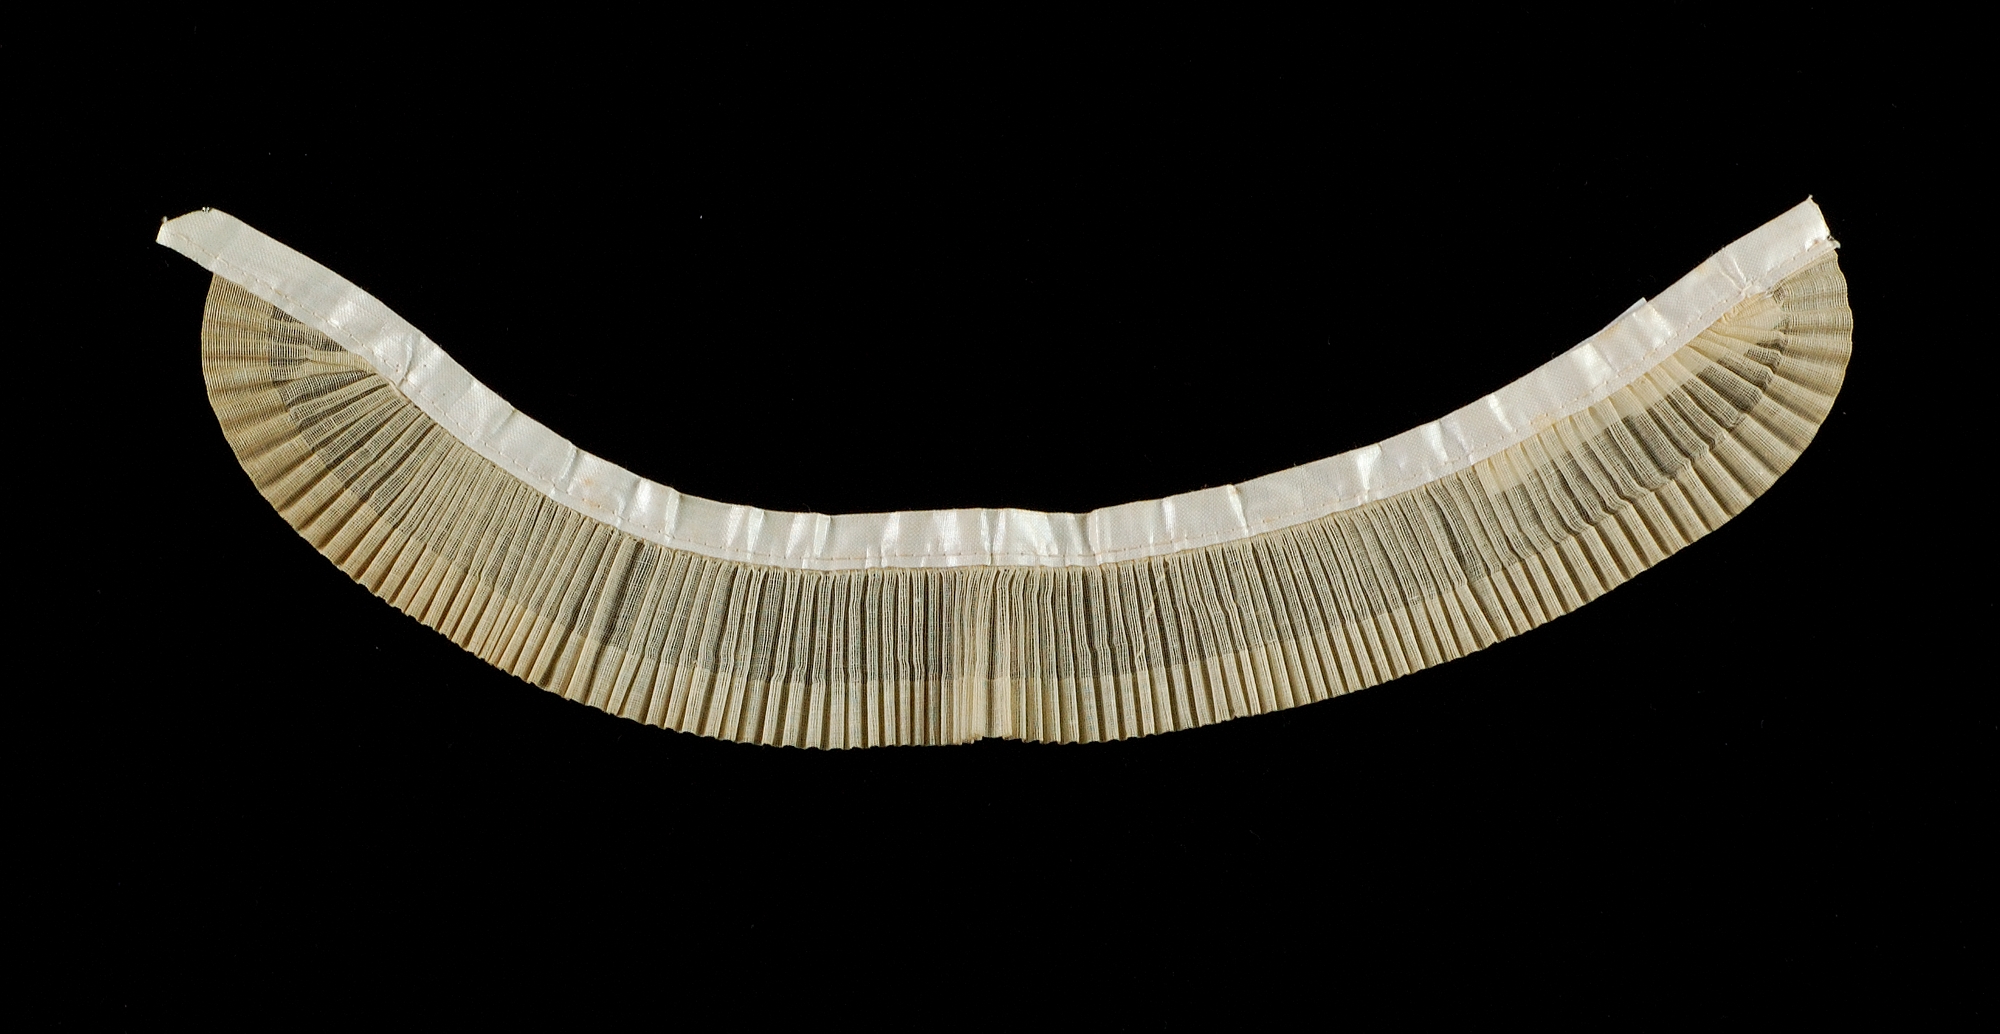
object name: collar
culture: american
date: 1870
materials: cotton